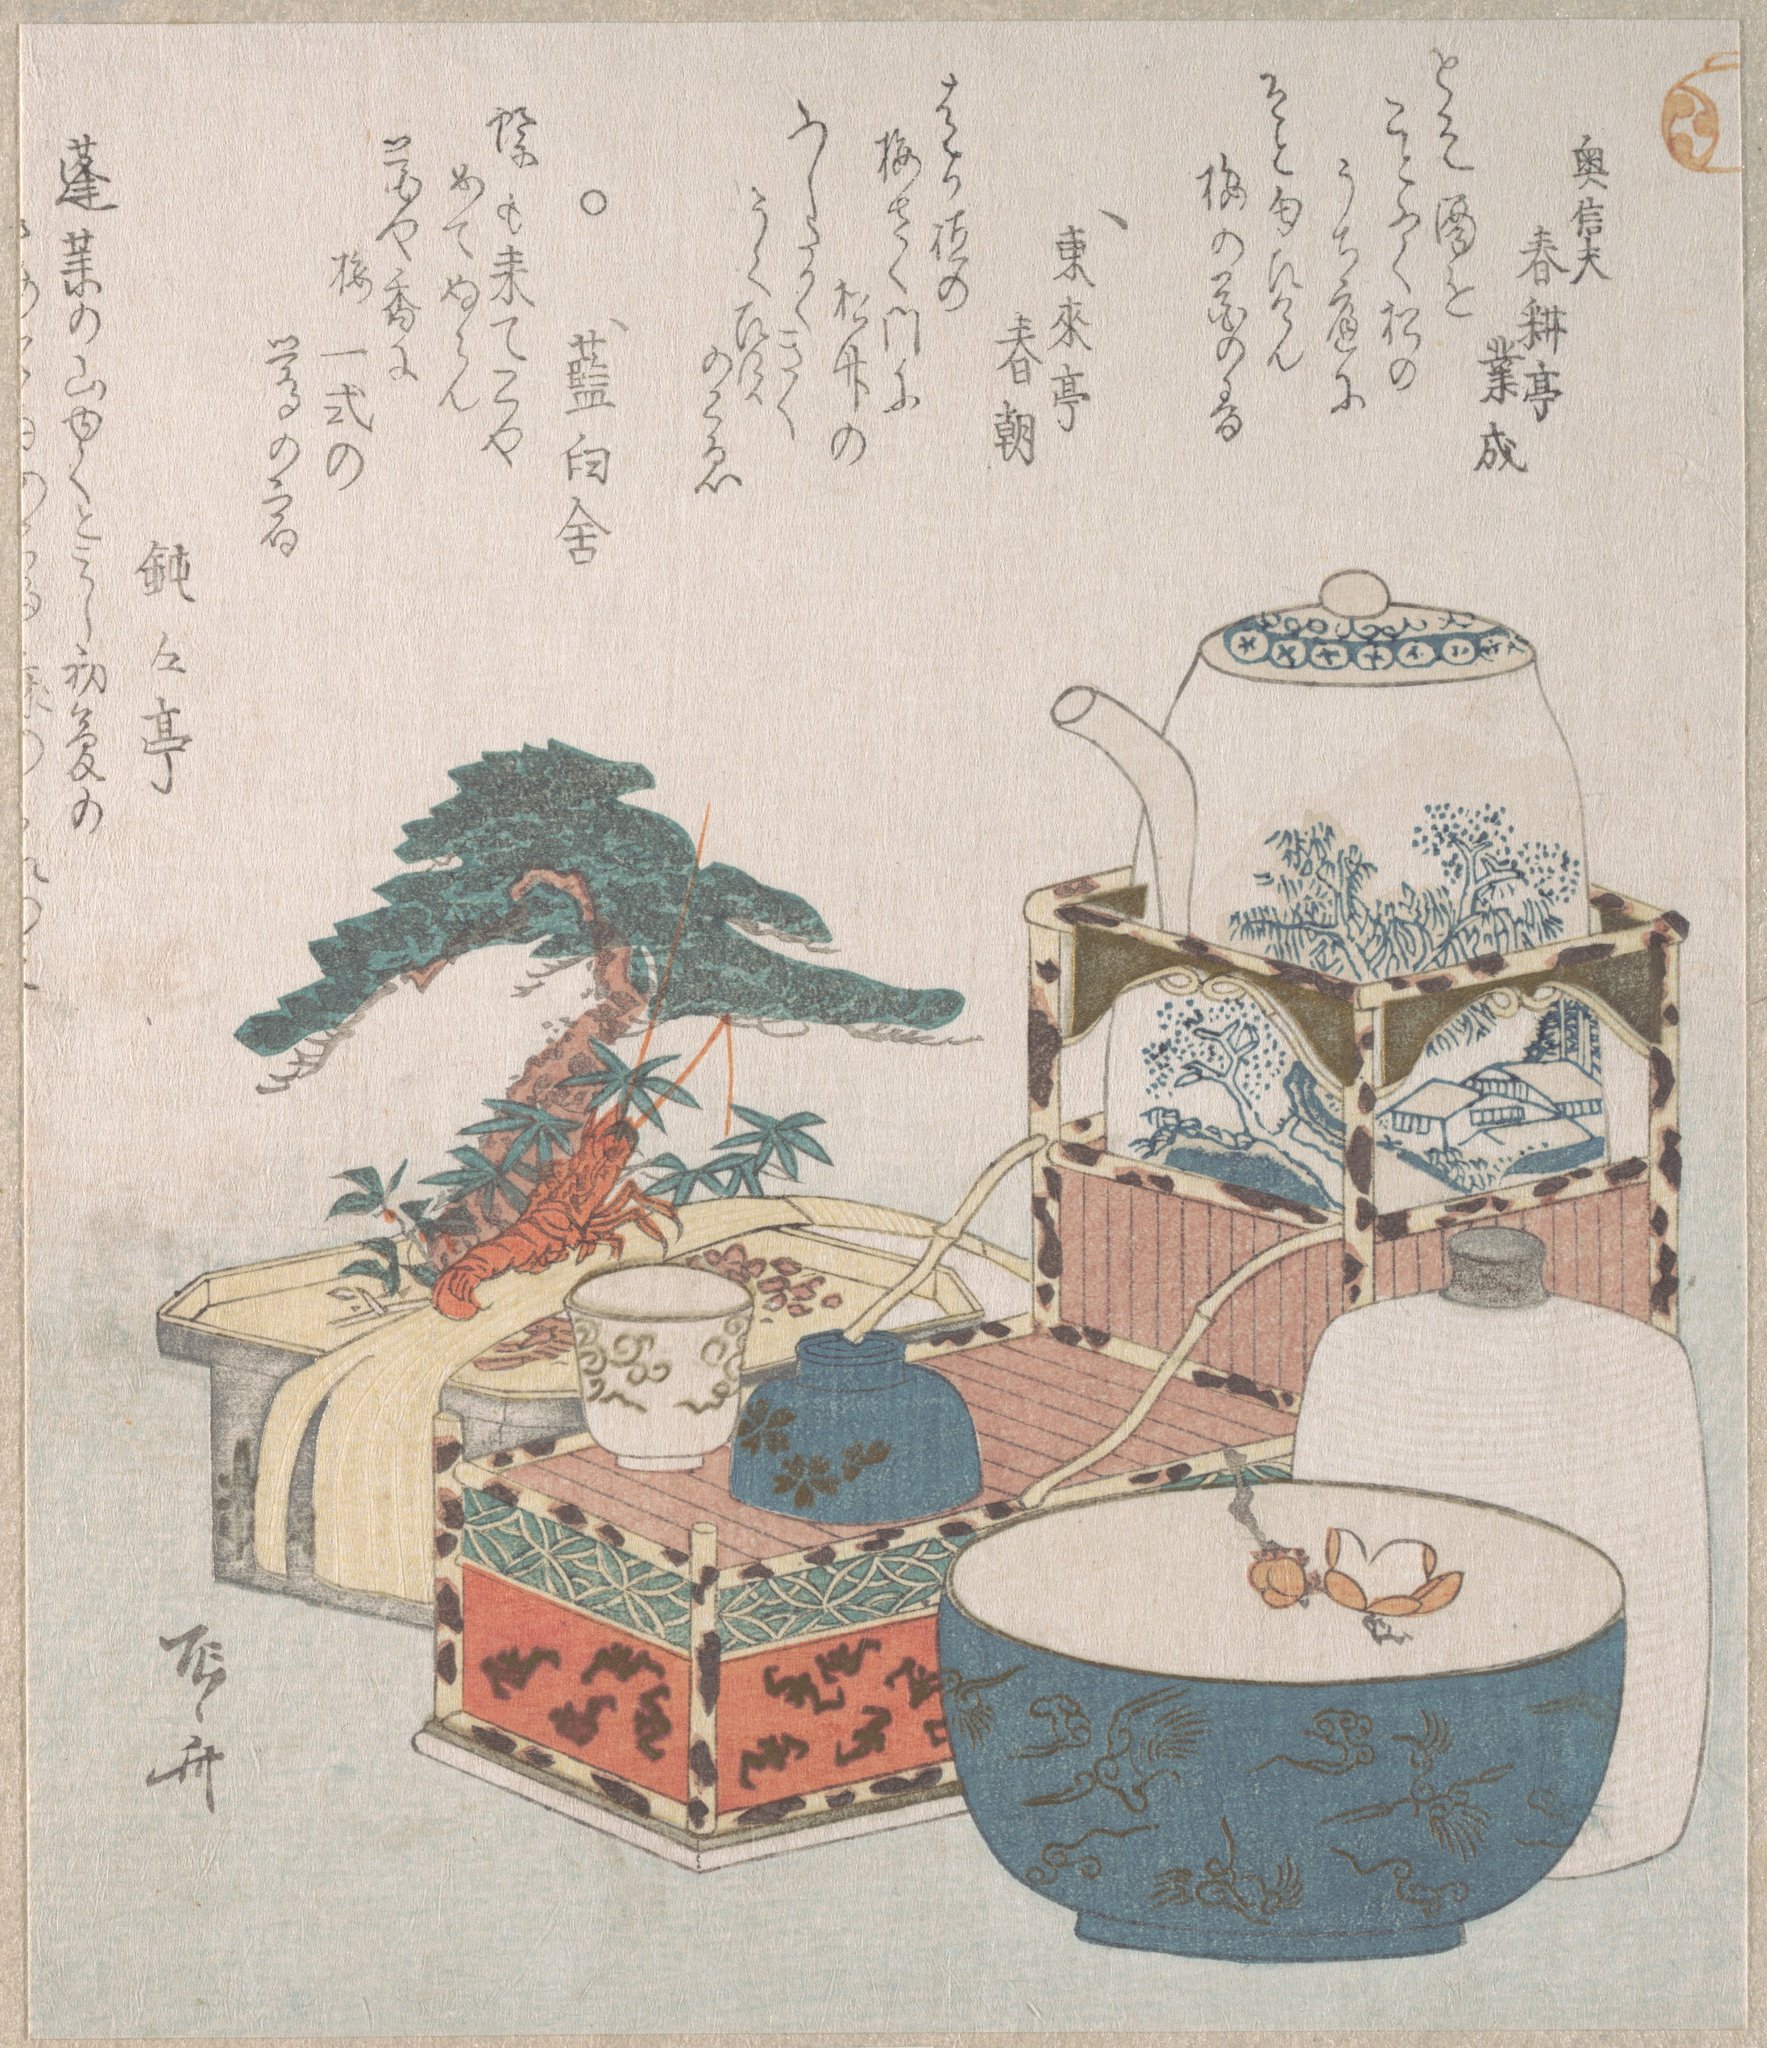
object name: print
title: Utensils with Decorations for the New Year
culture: japanese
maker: ryūryūkyo shinsai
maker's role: artist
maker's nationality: japanese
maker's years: 1799-1823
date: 1801-1900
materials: ink, paper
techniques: surimono, woodblock print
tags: lobsters